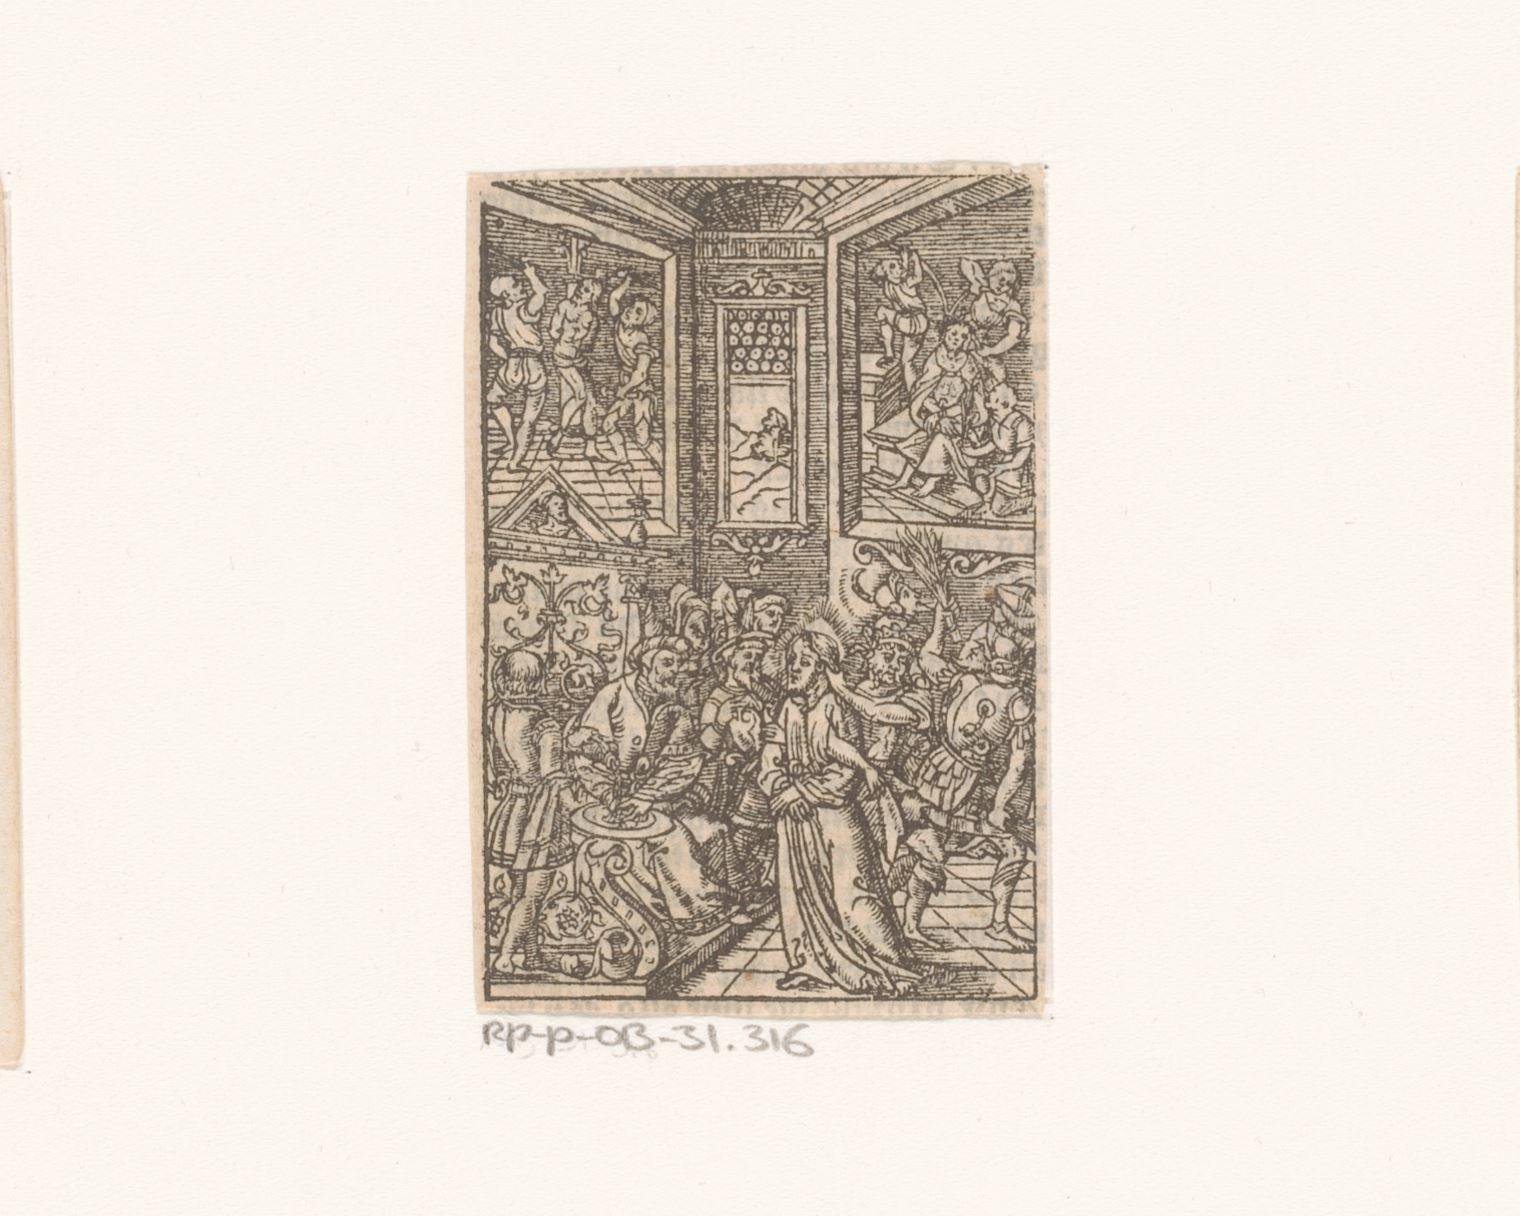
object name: book illustration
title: Pilatus wast zijn handen in onschuld, de geseling en de doornenkroning van Christus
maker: Anonymous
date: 1600-1699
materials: paper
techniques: letterpress printing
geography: netherlands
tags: pilate washing his hands (in innocence), the crowning with thorns: soldiers with sticks place a thorny crown on christ's head and give him a reed (matthew 27:27-31; mark 15:16-20; john 19:2-3), flagellation by soldiers, christ usually tied to a column (matthew 27:26; mark 15:15; john 19:1)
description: Pilatus heeft aan het volk gevraagd of hij Christus of Barabbas zal vrij laten. Het volk roept dat Barabbas moet worden vrijgelaten en dat Christus moet worden gekruisigd. Pilatus wast zijn handen in onschuld. Op de achtergrond wordt Christus, gekleed in een lendendoek en vastgebonden aan een pilaar, door twee mannen geschopt en geslagen met een gesel en roedes. Rechts op de achtergrond zetten mannen Christus met stokken een doornenkroon op het hoofd. Een man knielt voor hem en geeft hem een rietstok in de hand.